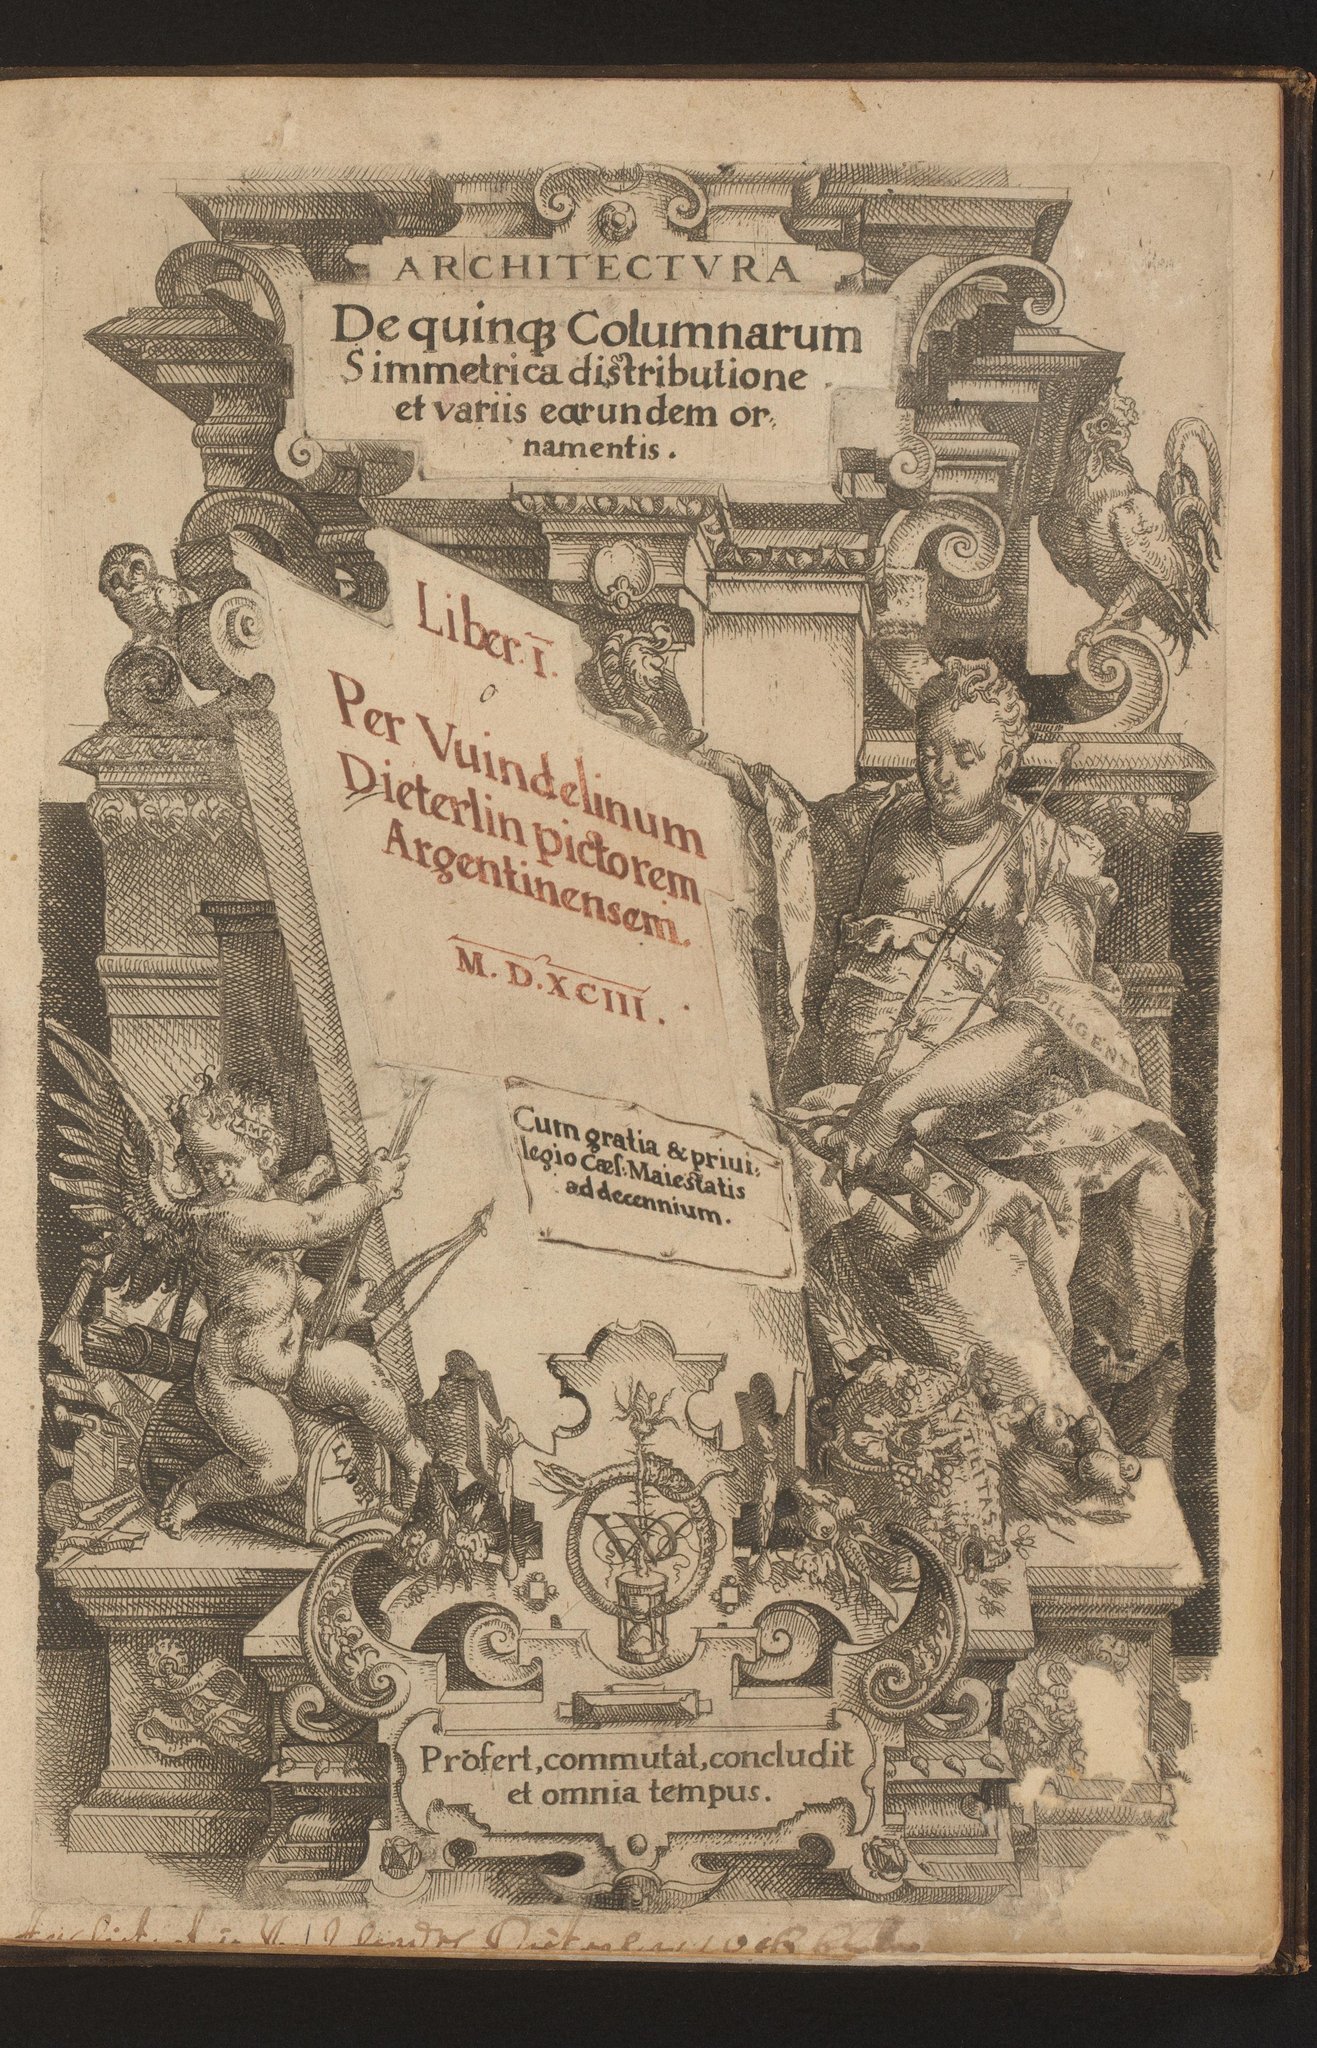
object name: titelblad, titelpagina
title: Architectura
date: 1593-1595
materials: paper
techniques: etching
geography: straatsburg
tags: architectural detail, (story of) cupid, amor (eros), fowl (cock, hen, chicken, etc.), carefulness, diligence; 'diligenza' (ripa)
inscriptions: collector's mark: Lugt 2760, collector's mark: Lugt 2228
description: Prent gebruikt in: Dietterlin, Wendel (I). Architectura de quinq[ue] columnarum simmetrica distributione et variis eorundem or namentis: Liber I. Straatsburg: Bernhard Jobin, 1593.